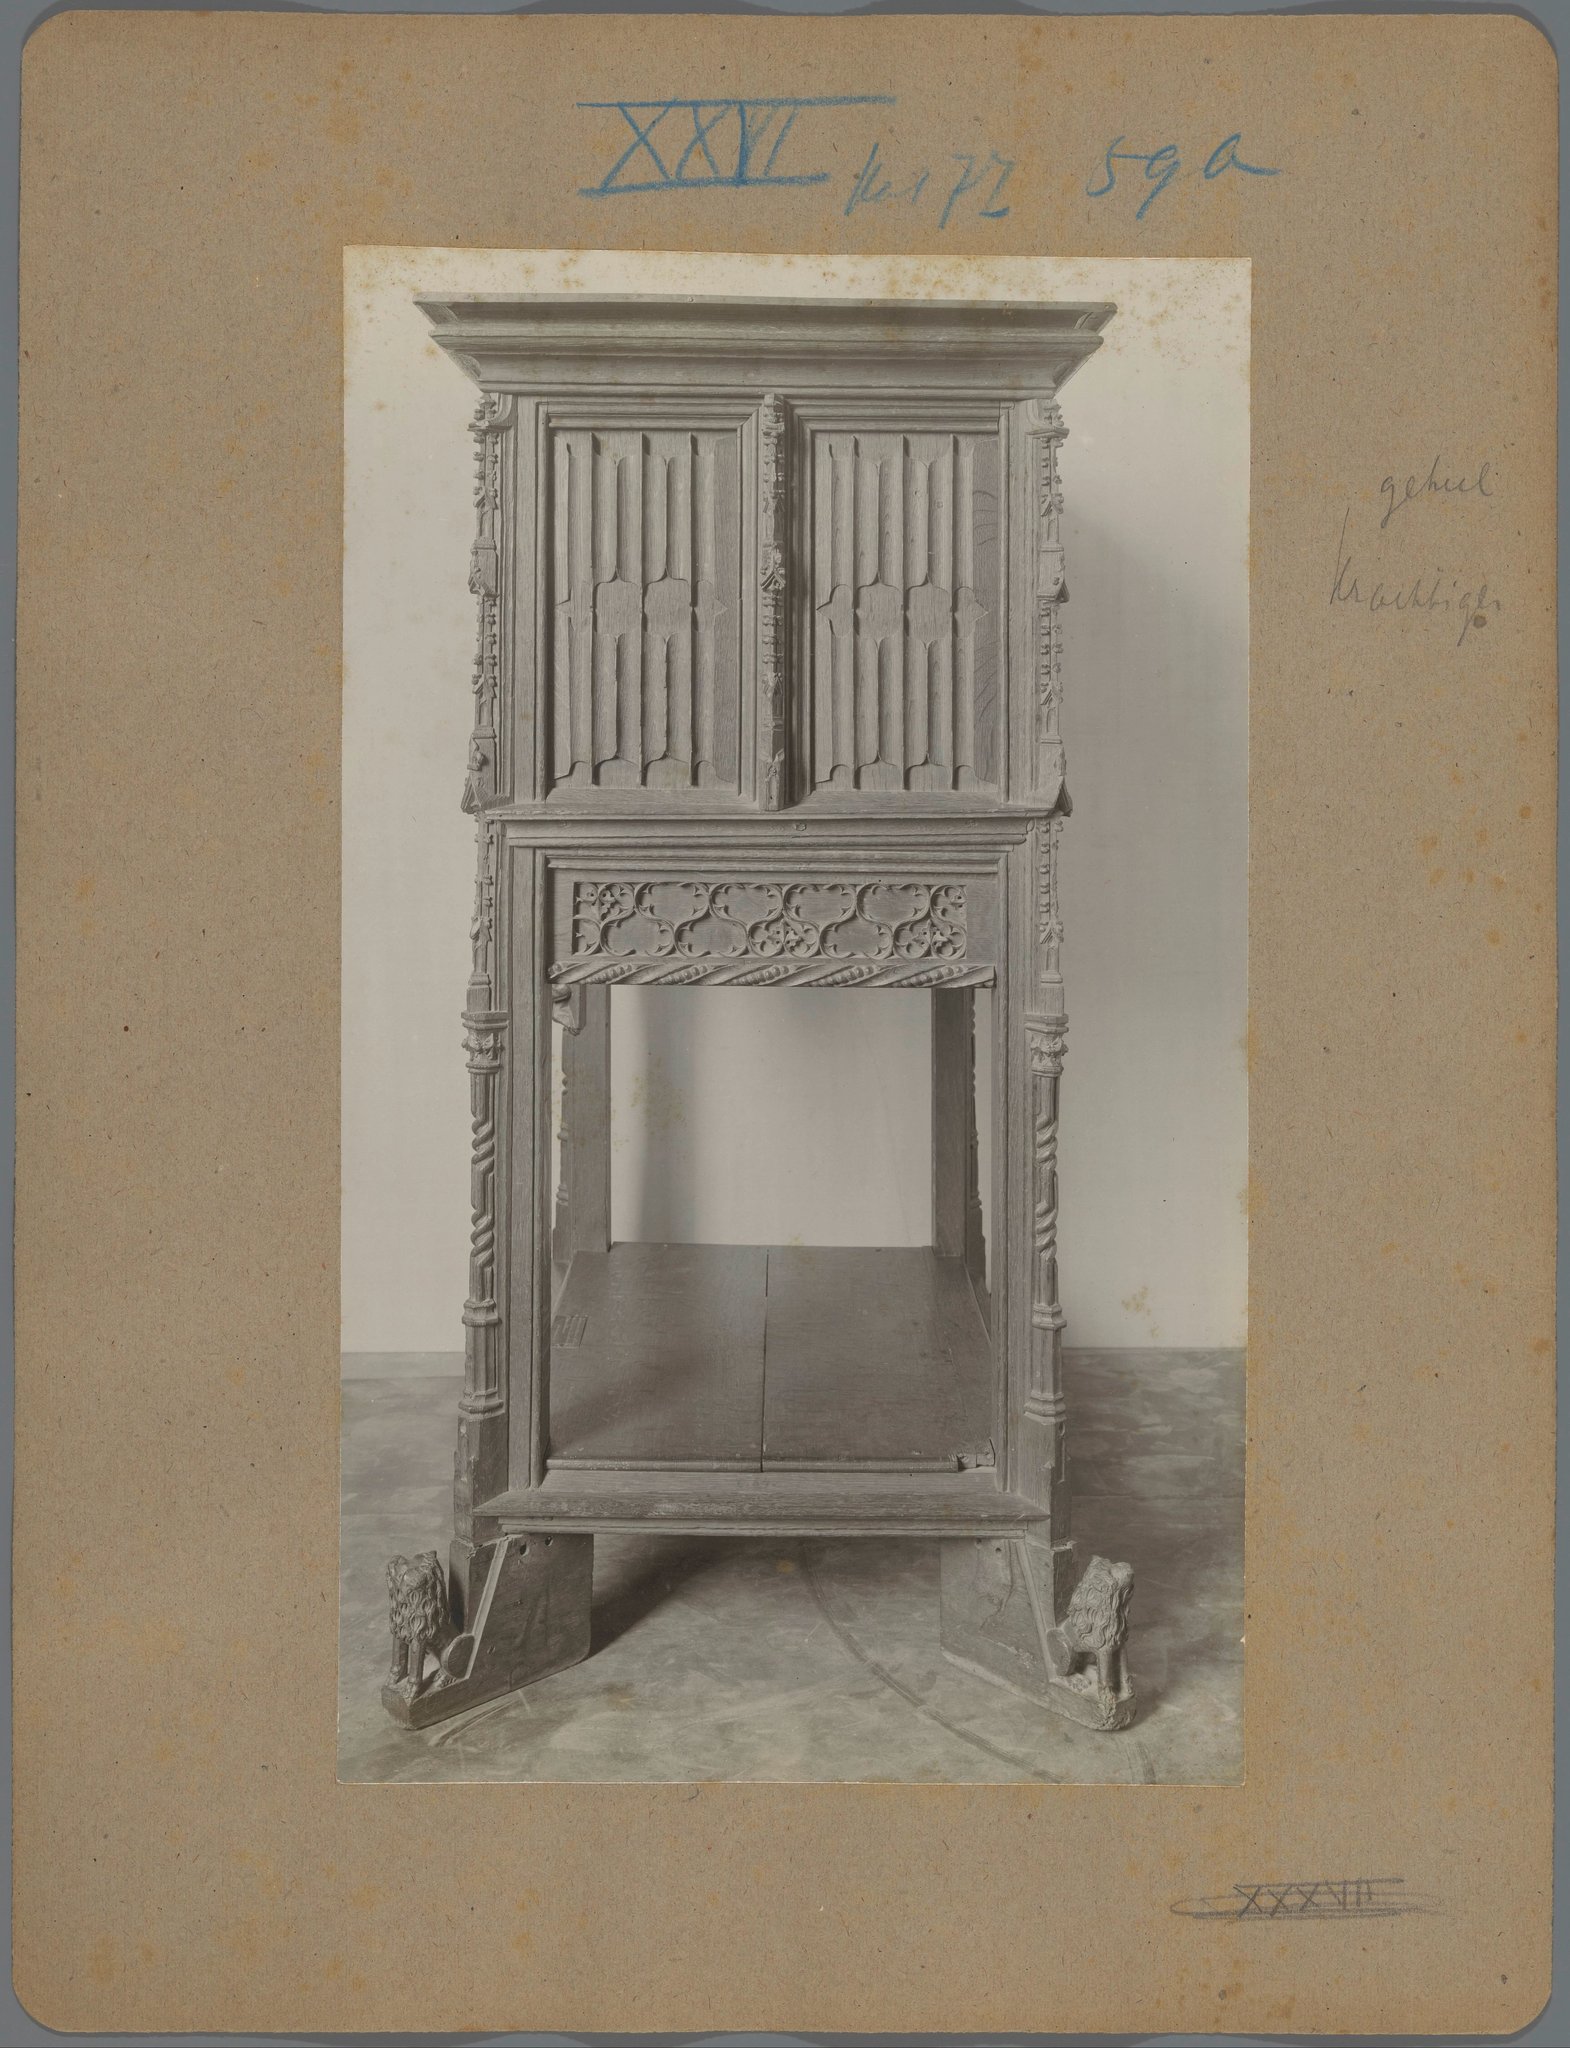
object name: photograph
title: Zijkant van een dressoir uit het provenhuis (hofje) Paling en Van Foreest te Alkmaar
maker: Anonymous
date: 1875-1900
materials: cardboard, photographic support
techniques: gelatin silver print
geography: amsterdam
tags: cupboard, beasts of prey, predatory animals: lion, amsterdam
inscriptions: collector's mark: ‘KUNSTNIJVERHEIDSCHOOL QUELLINUS AMSTERDAM FRANS HALSSTRAAT 14.’, number: ‘59 a’, number: ‘Kat 172’, number: ‘XXVI’, collector's mark: ‘INSTITUUT VOOR KUNST-NIJVERHEIDSONDERWIJS GABRIËL METSUSTRAAT No. 16 AMSTERDAM’